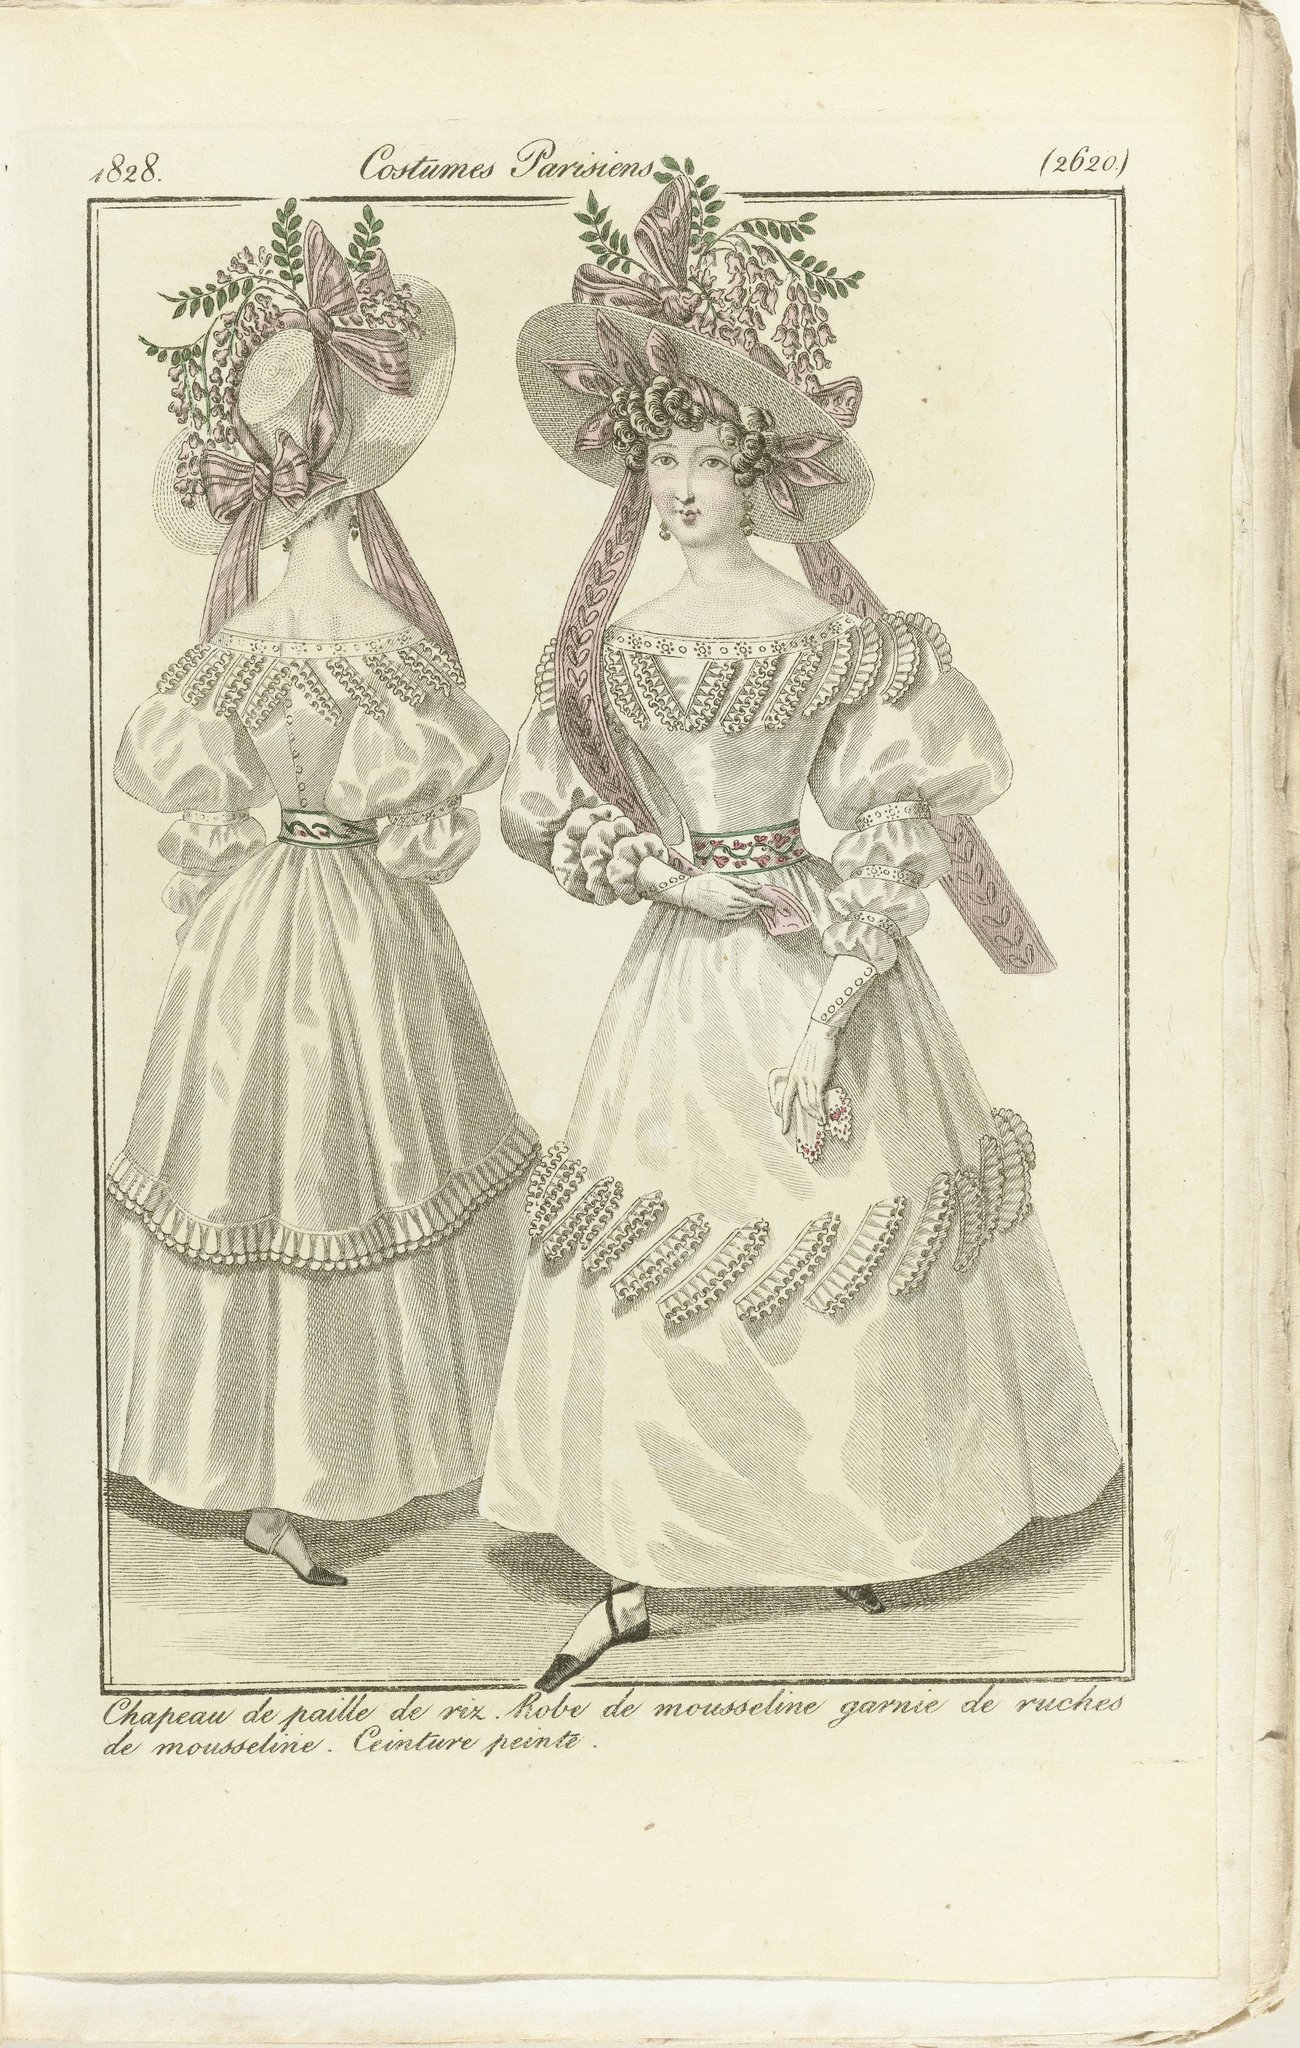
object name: fashion print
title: Journal des Dames et des Modes 1828, Costumes Parisiens (2620)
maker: Anonymous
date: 1828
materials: paper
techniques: etching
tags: fashion plates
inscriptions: date